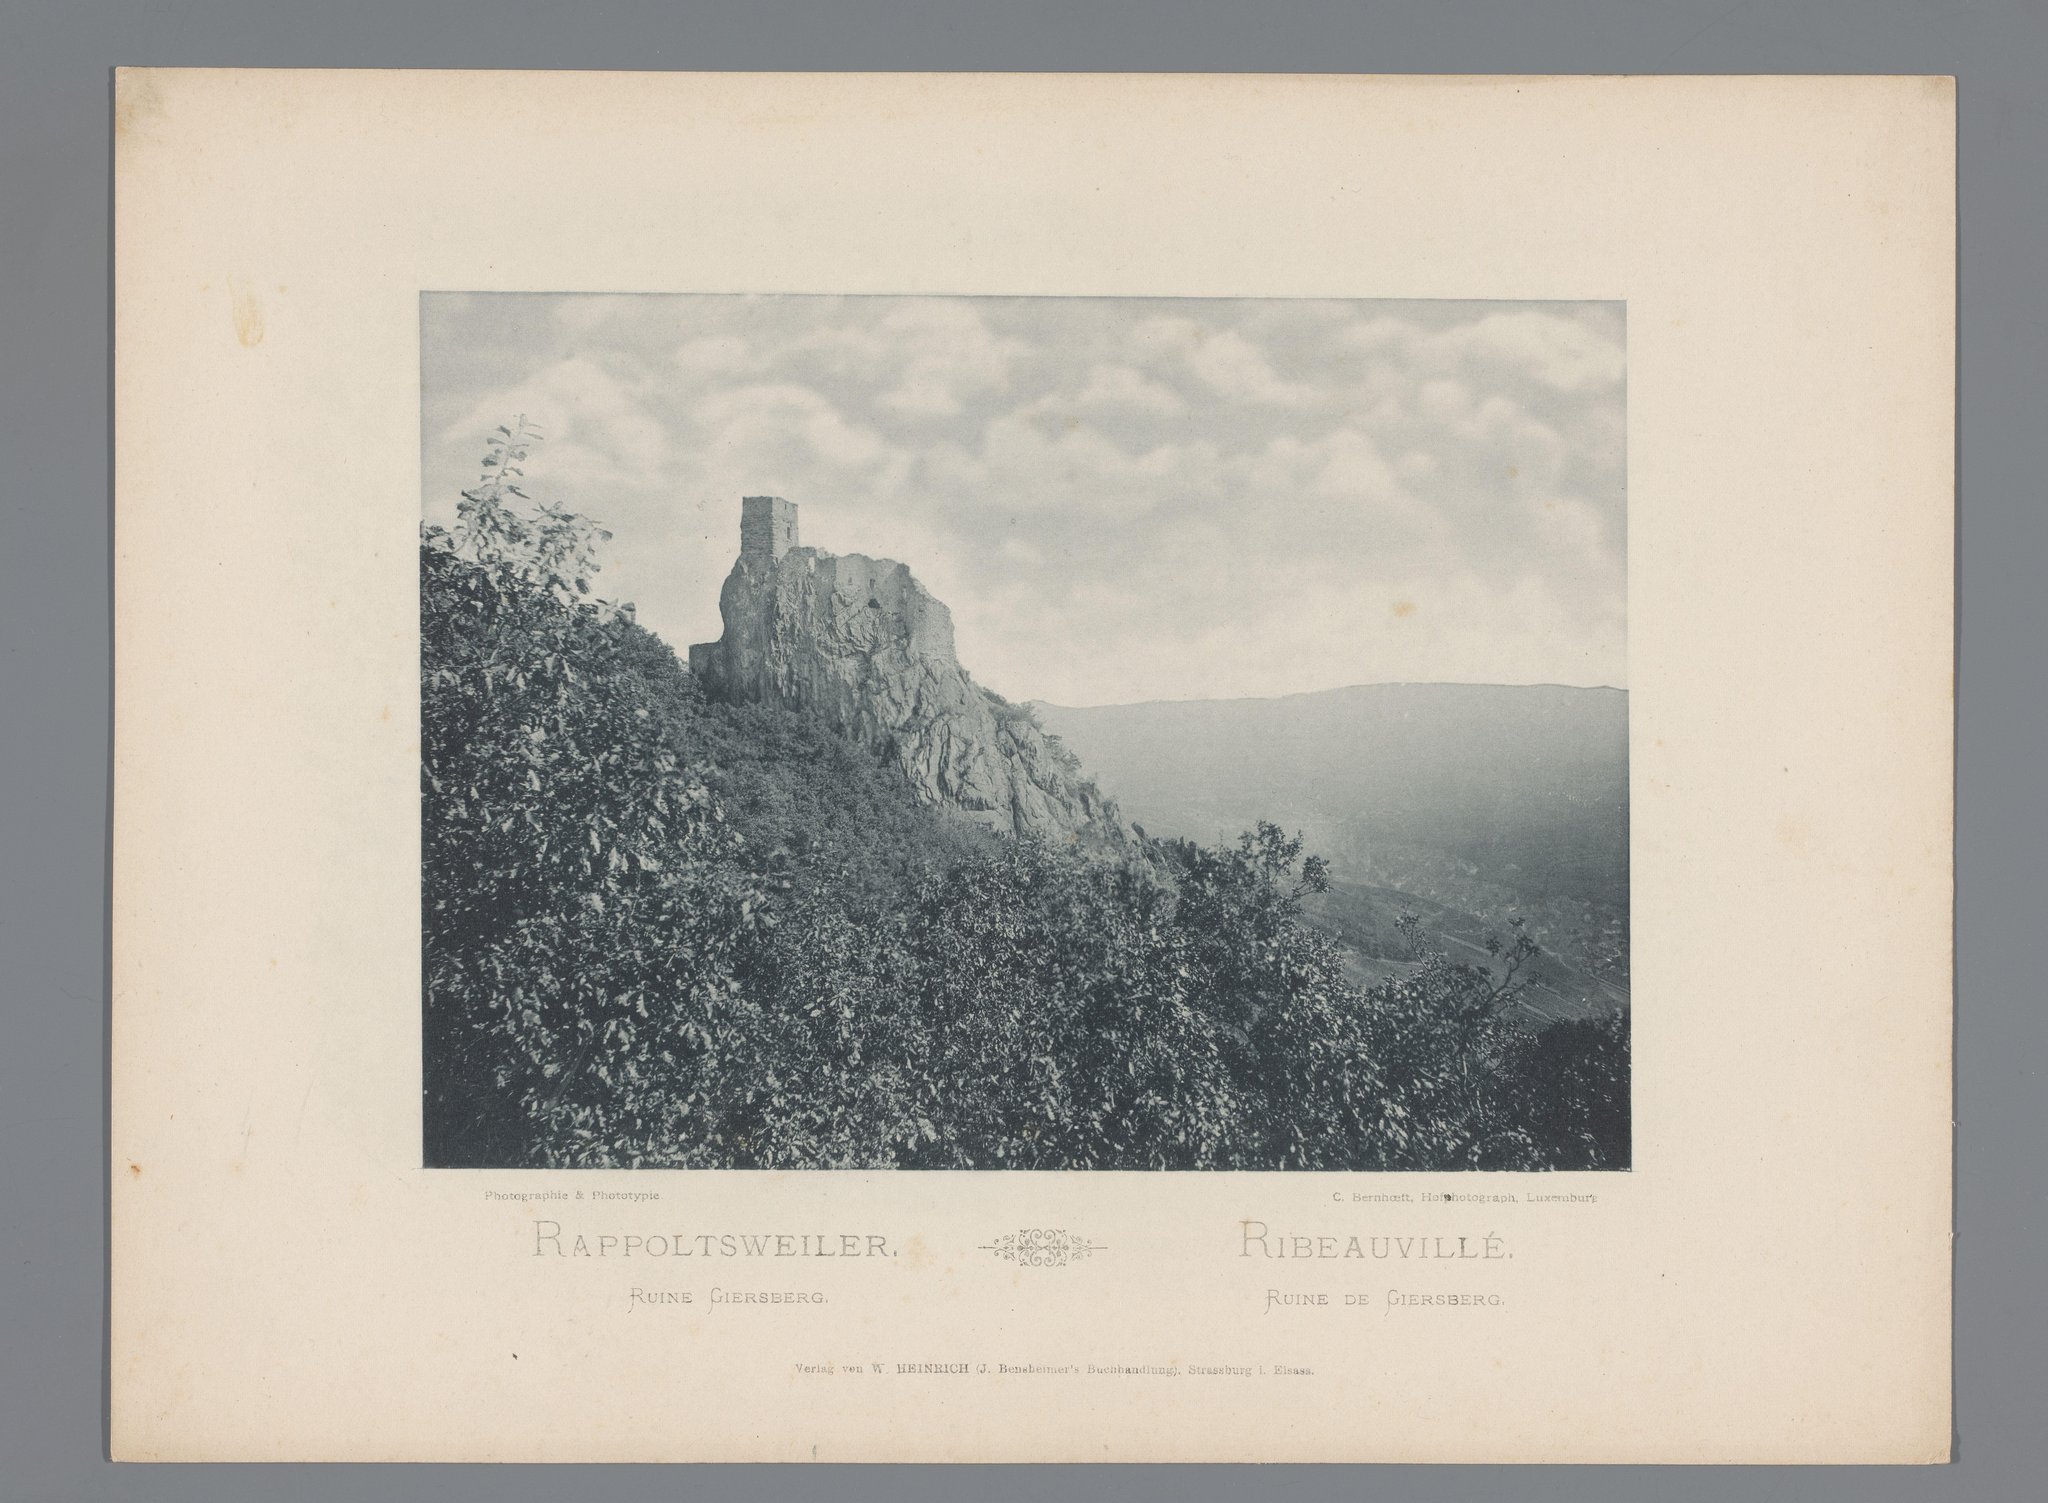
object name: page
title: Gezicht op Château du Girsberg te Ribeauvillé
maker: charles bernhoeft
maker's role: publisher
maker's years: 1859-1933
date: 1889-1894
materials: paper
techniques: photograph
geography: straatsburg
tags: castle, landscape with ruins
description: Deze prent maakt deel uit van een omslag met 100 prenten.